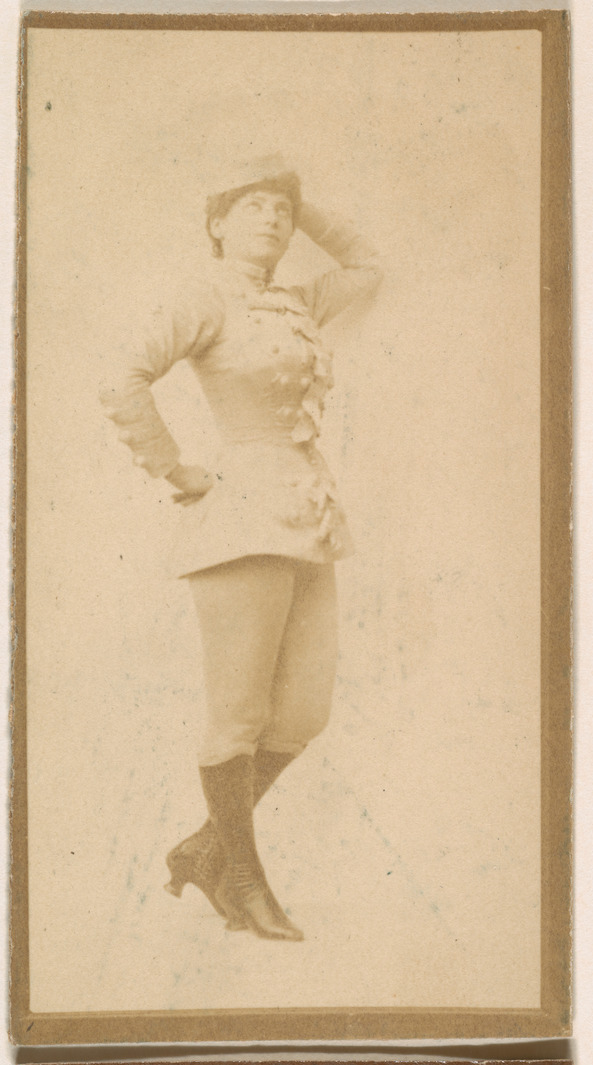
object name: photograph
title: Actress leaning against wall, from the Actresses series (N664) promoting Old Fashion Fine Cut Tobacco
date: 1888-1890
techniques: albumen silver print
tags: portraits,women,actresses